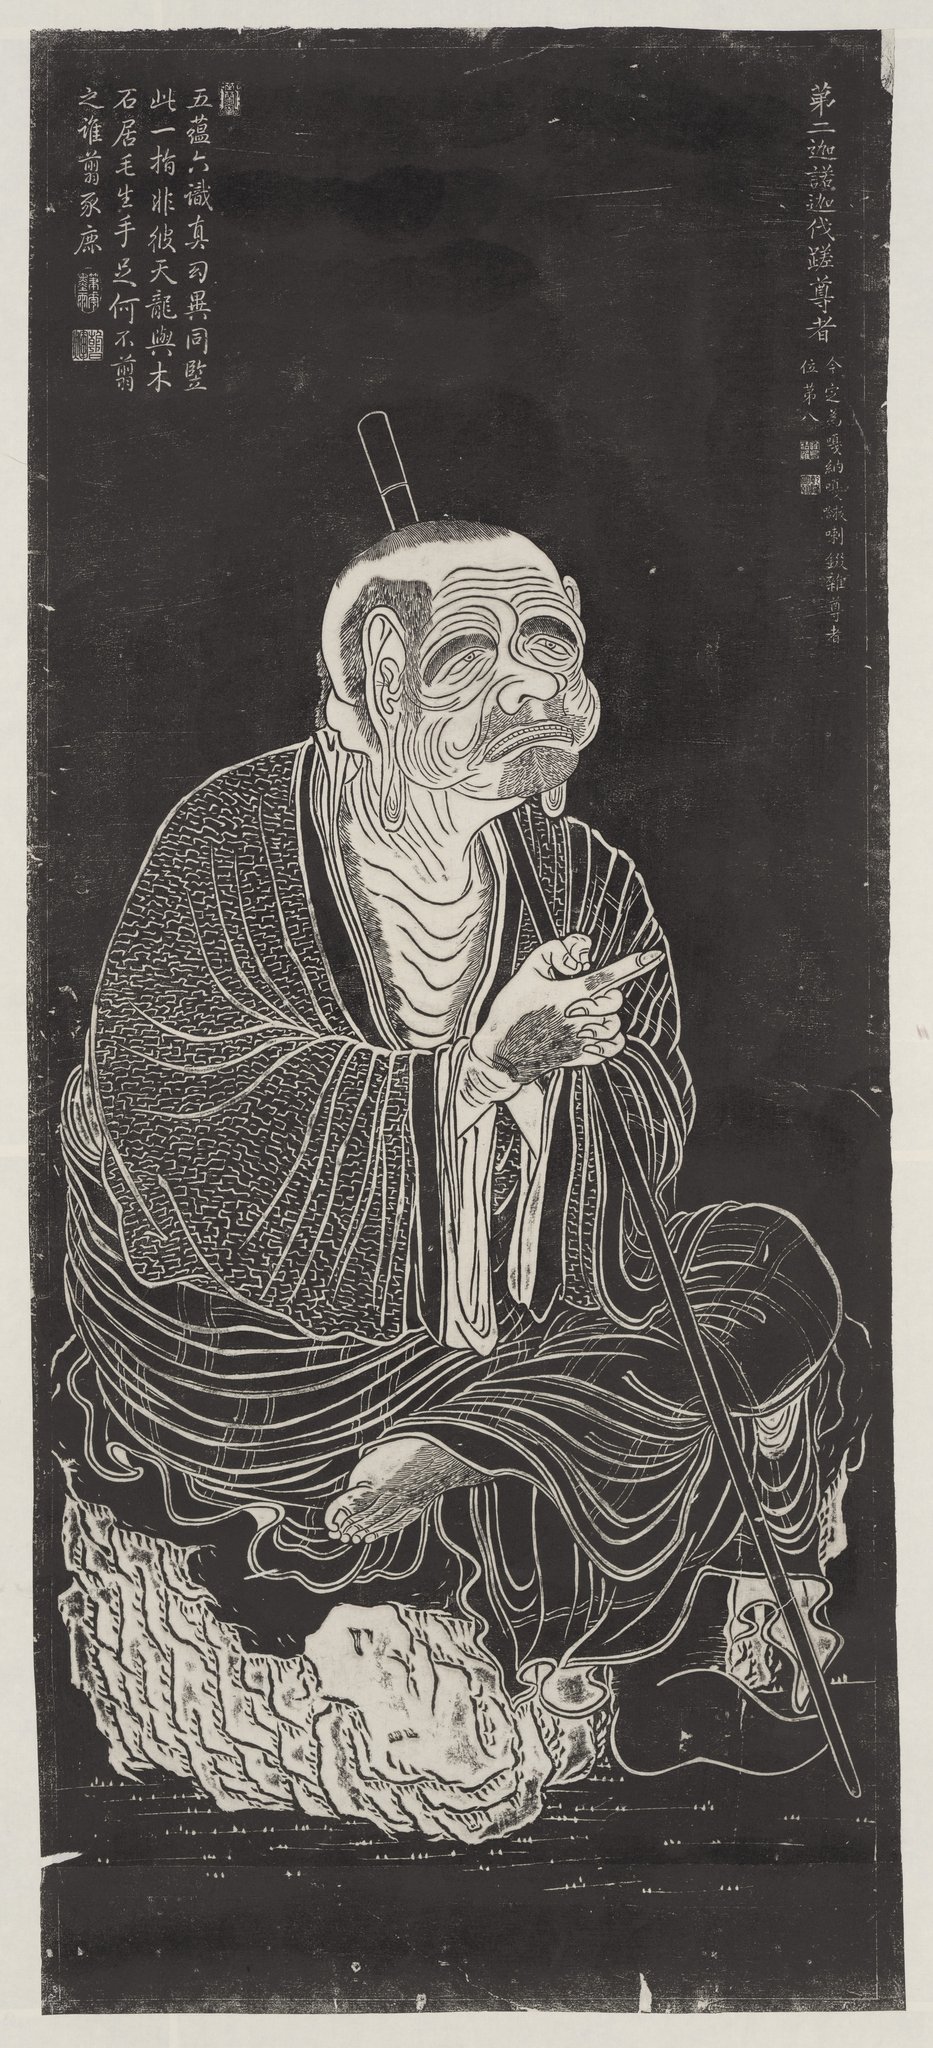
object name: rubbing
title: Luohan, after a set attributed to Guanxiu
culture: chinese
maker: unidentified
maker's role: artist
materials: ink, paper